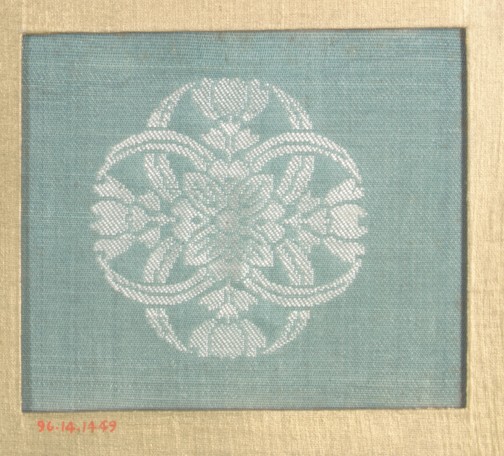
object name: piece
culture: japanese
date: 1701-1900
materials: silk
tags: flowers